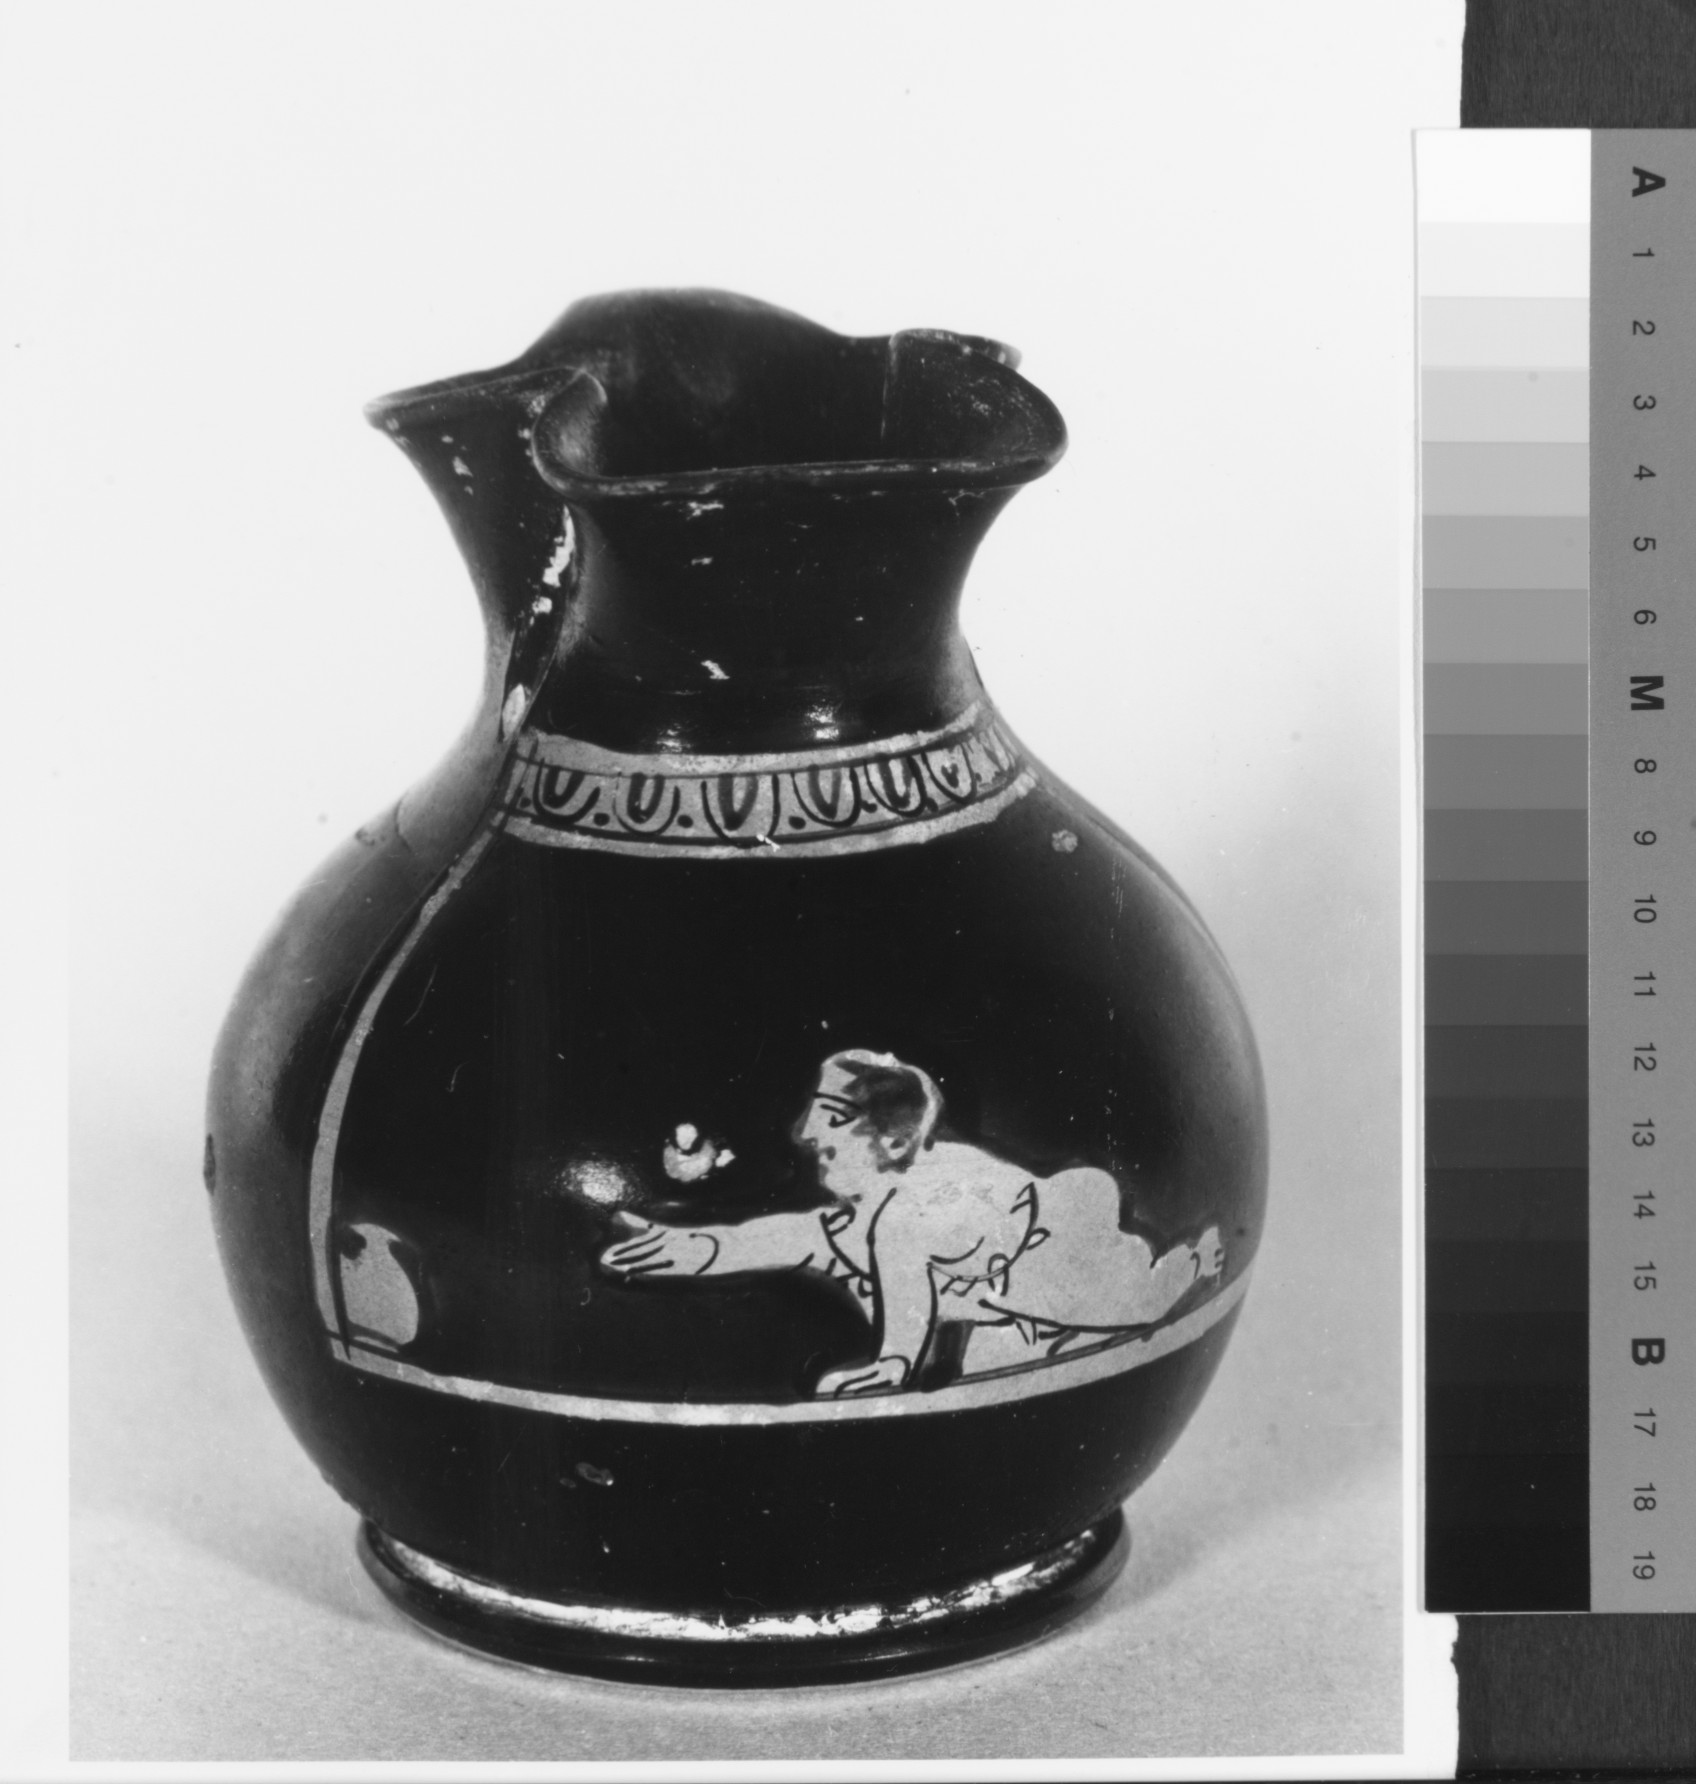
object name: oinochoe, miniature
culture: greek, attic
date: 434-401 BCE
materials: terracotta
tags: boys